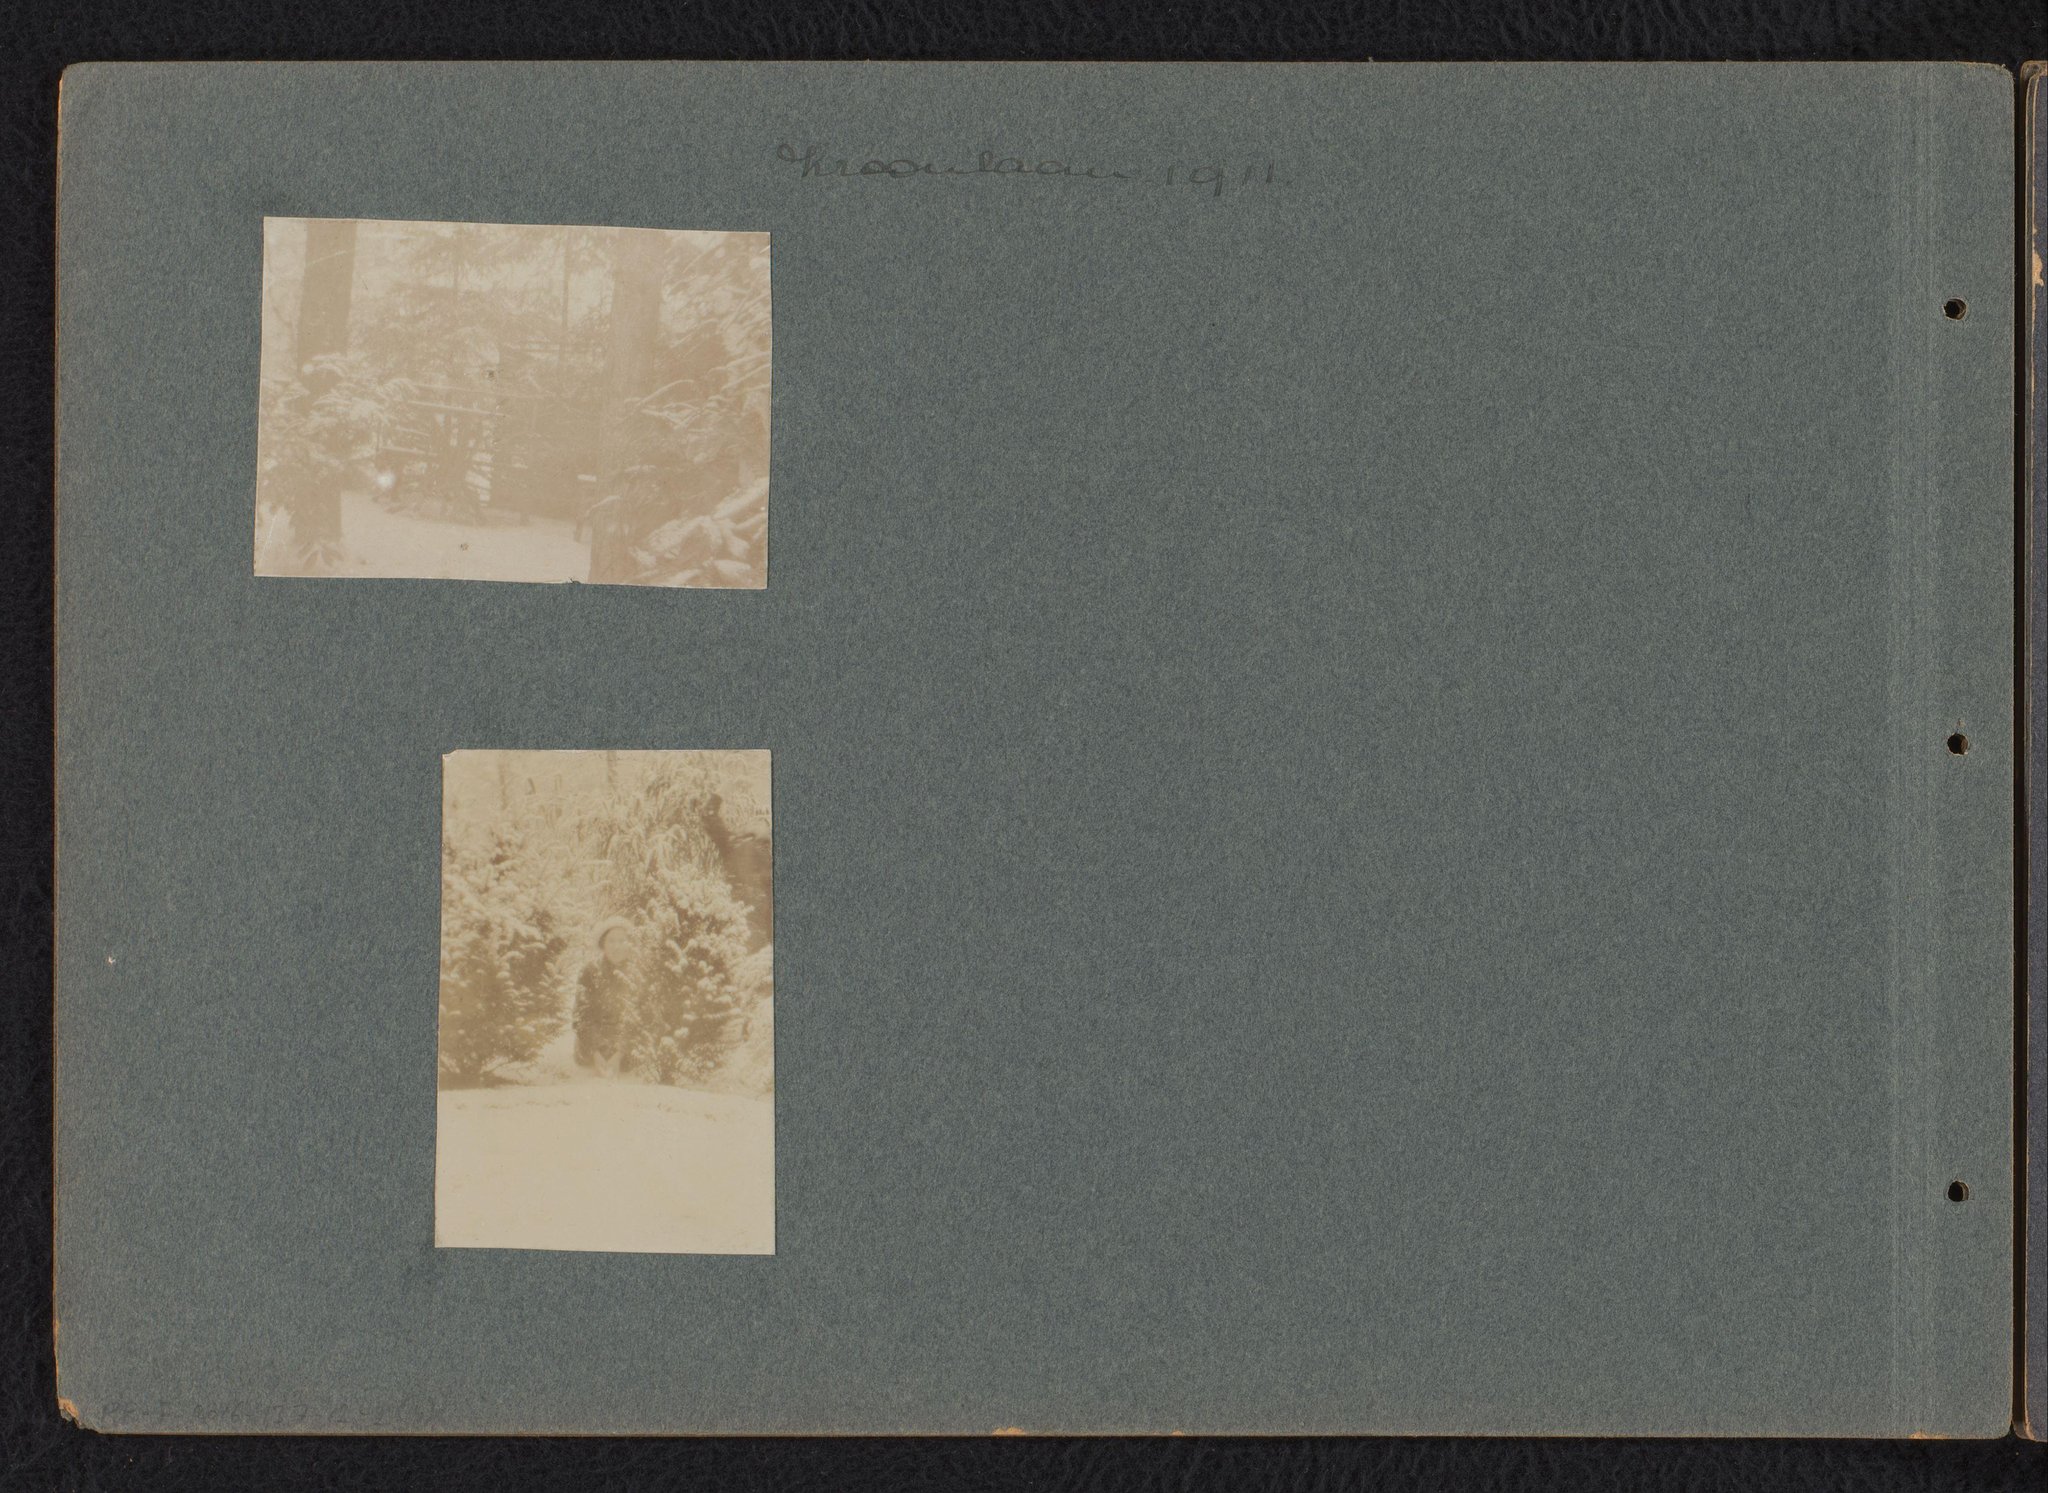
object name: album leaf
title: Besneeuwde tuin aan de Kroonlaan in Hilversum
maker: carolina frederika onnen (lien/loen)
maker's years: 1896-1983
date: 1911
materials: paper, cardboard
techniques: collodion silver print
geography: hilversum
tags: garden, snow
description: Deze foto's zijn onderdeel van een album.